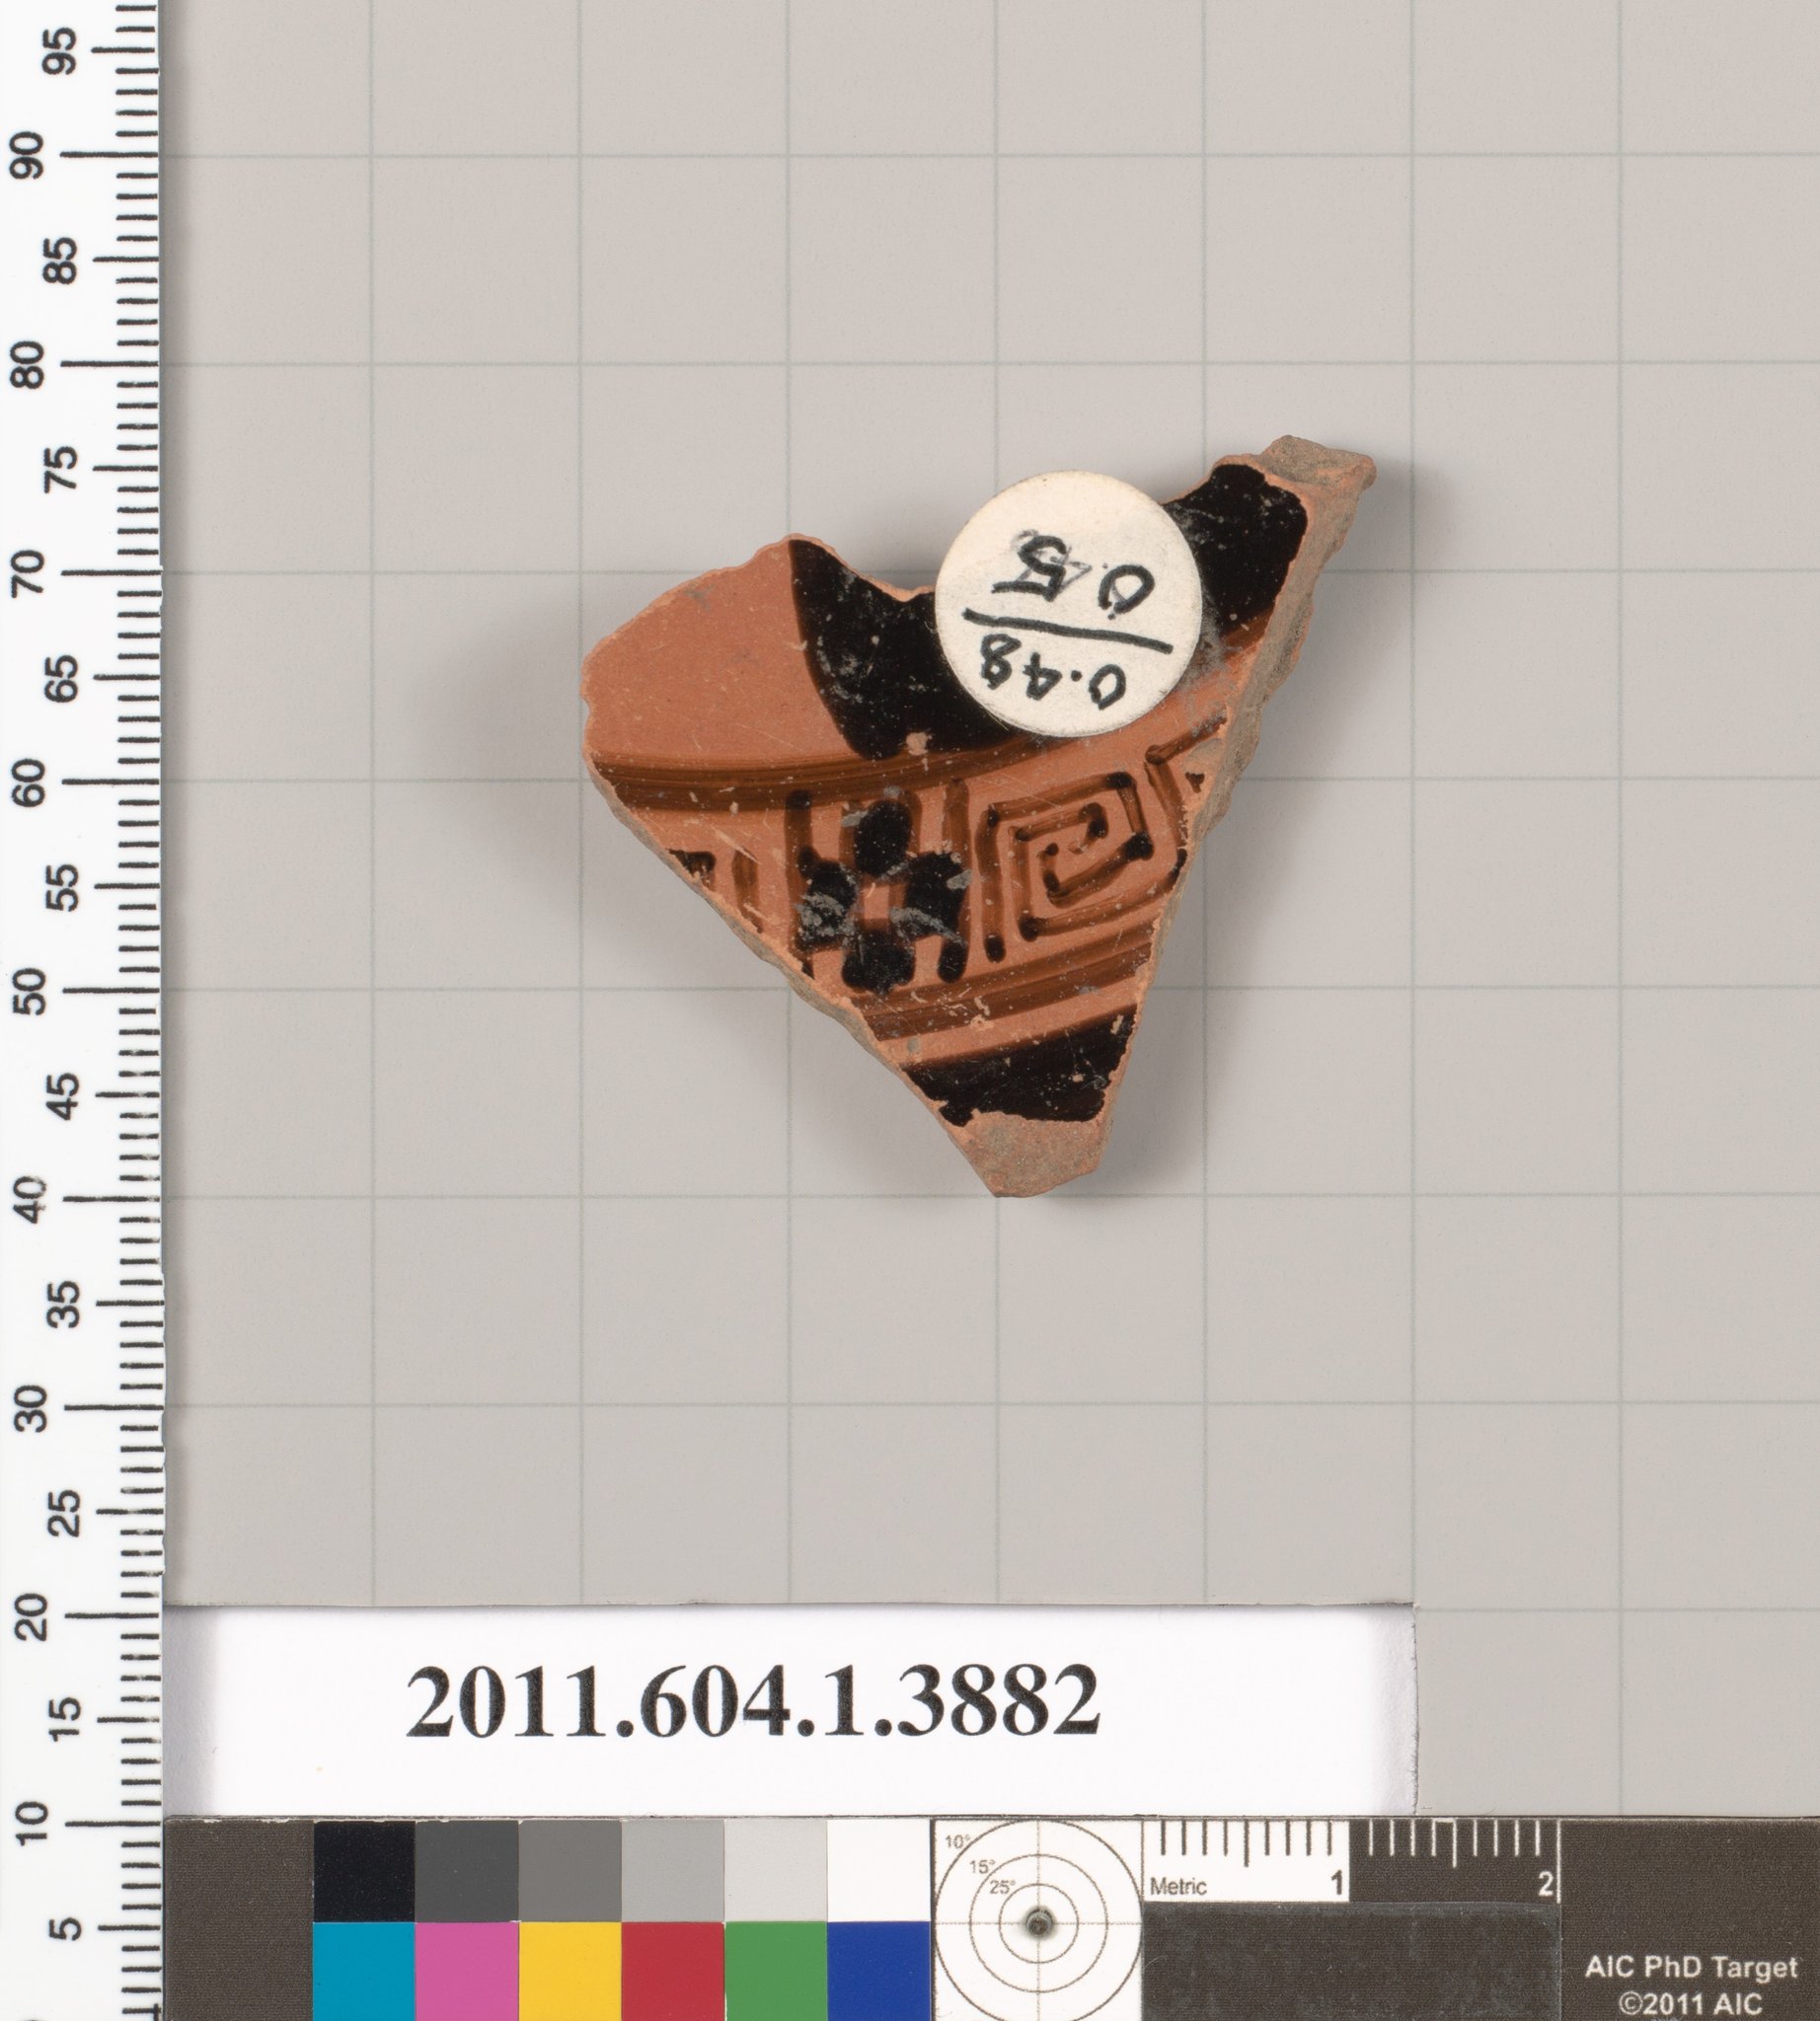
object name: kylix fragment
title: Terracotta fragment of a kylix (drinking cup)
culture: greek, attic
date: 460-440 BCE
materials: terracotta